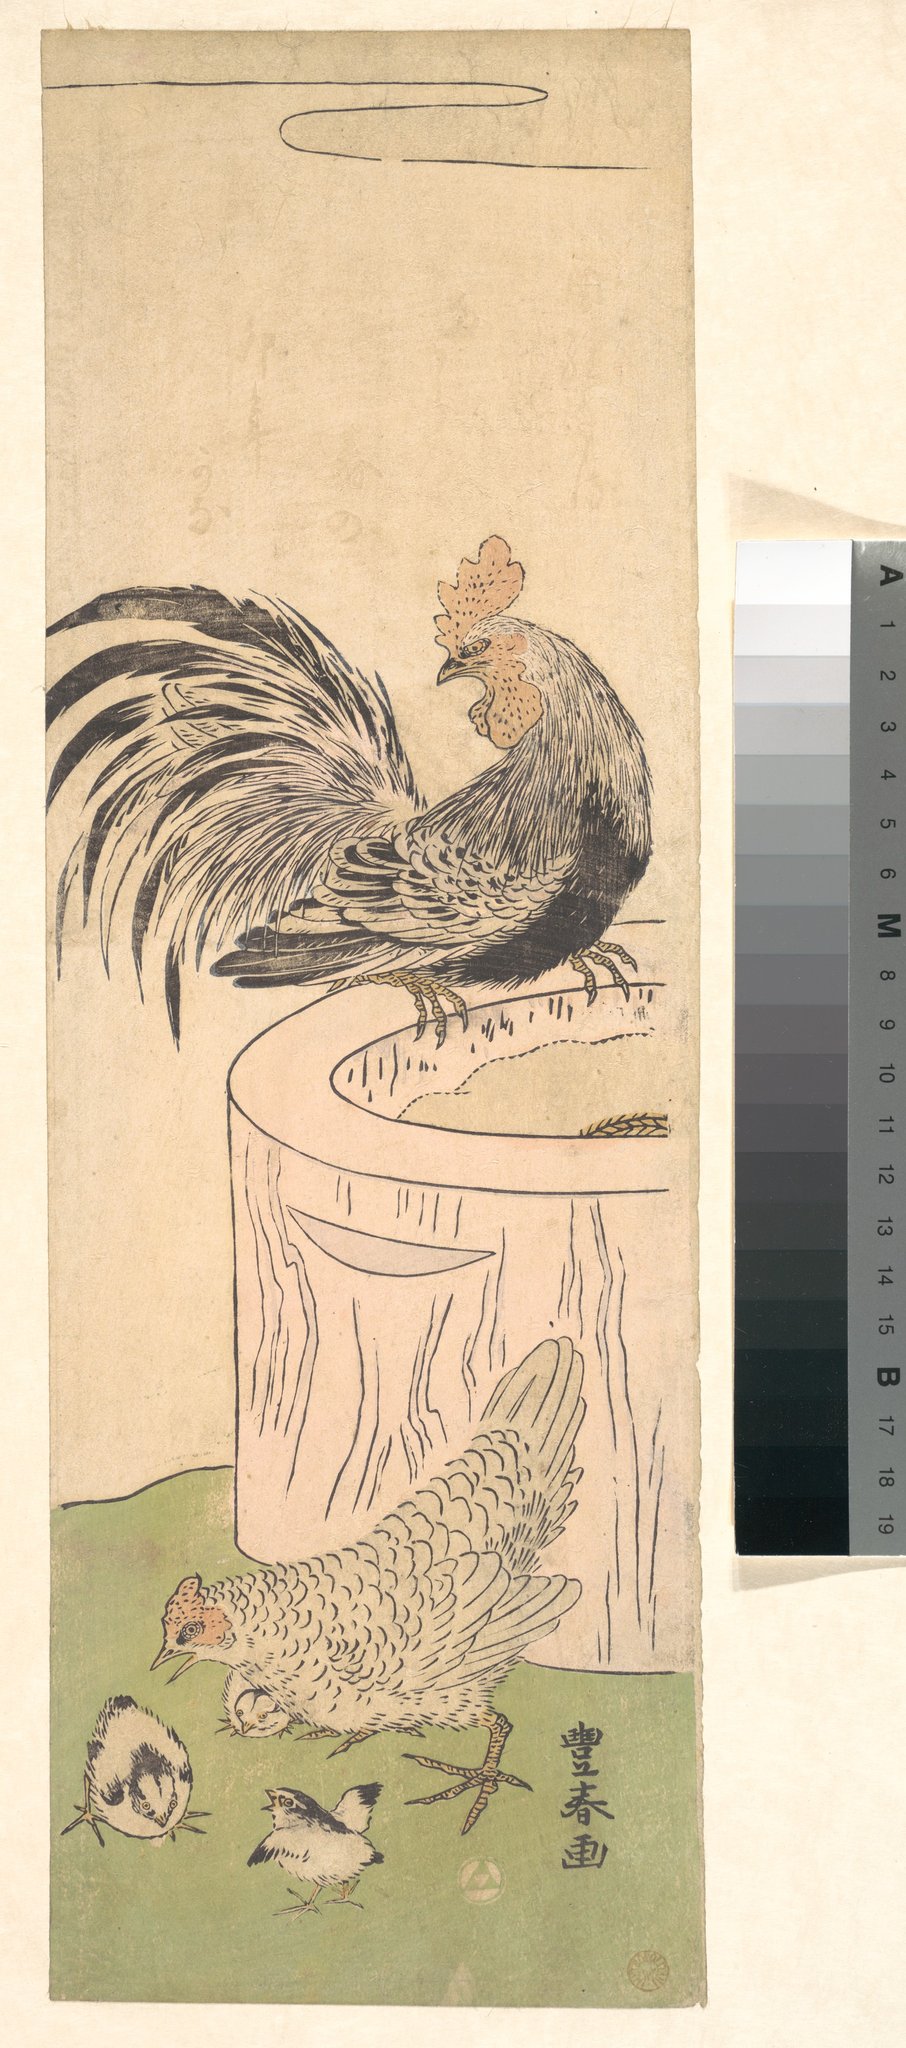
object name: print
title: Cock, Hen, and Chickens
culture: japanese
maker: utagawa toyoharu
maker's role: artist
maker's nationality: japanese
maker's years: 1735-1814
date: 1770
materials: ink, paper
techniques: woodblock print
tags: chickens,roosters